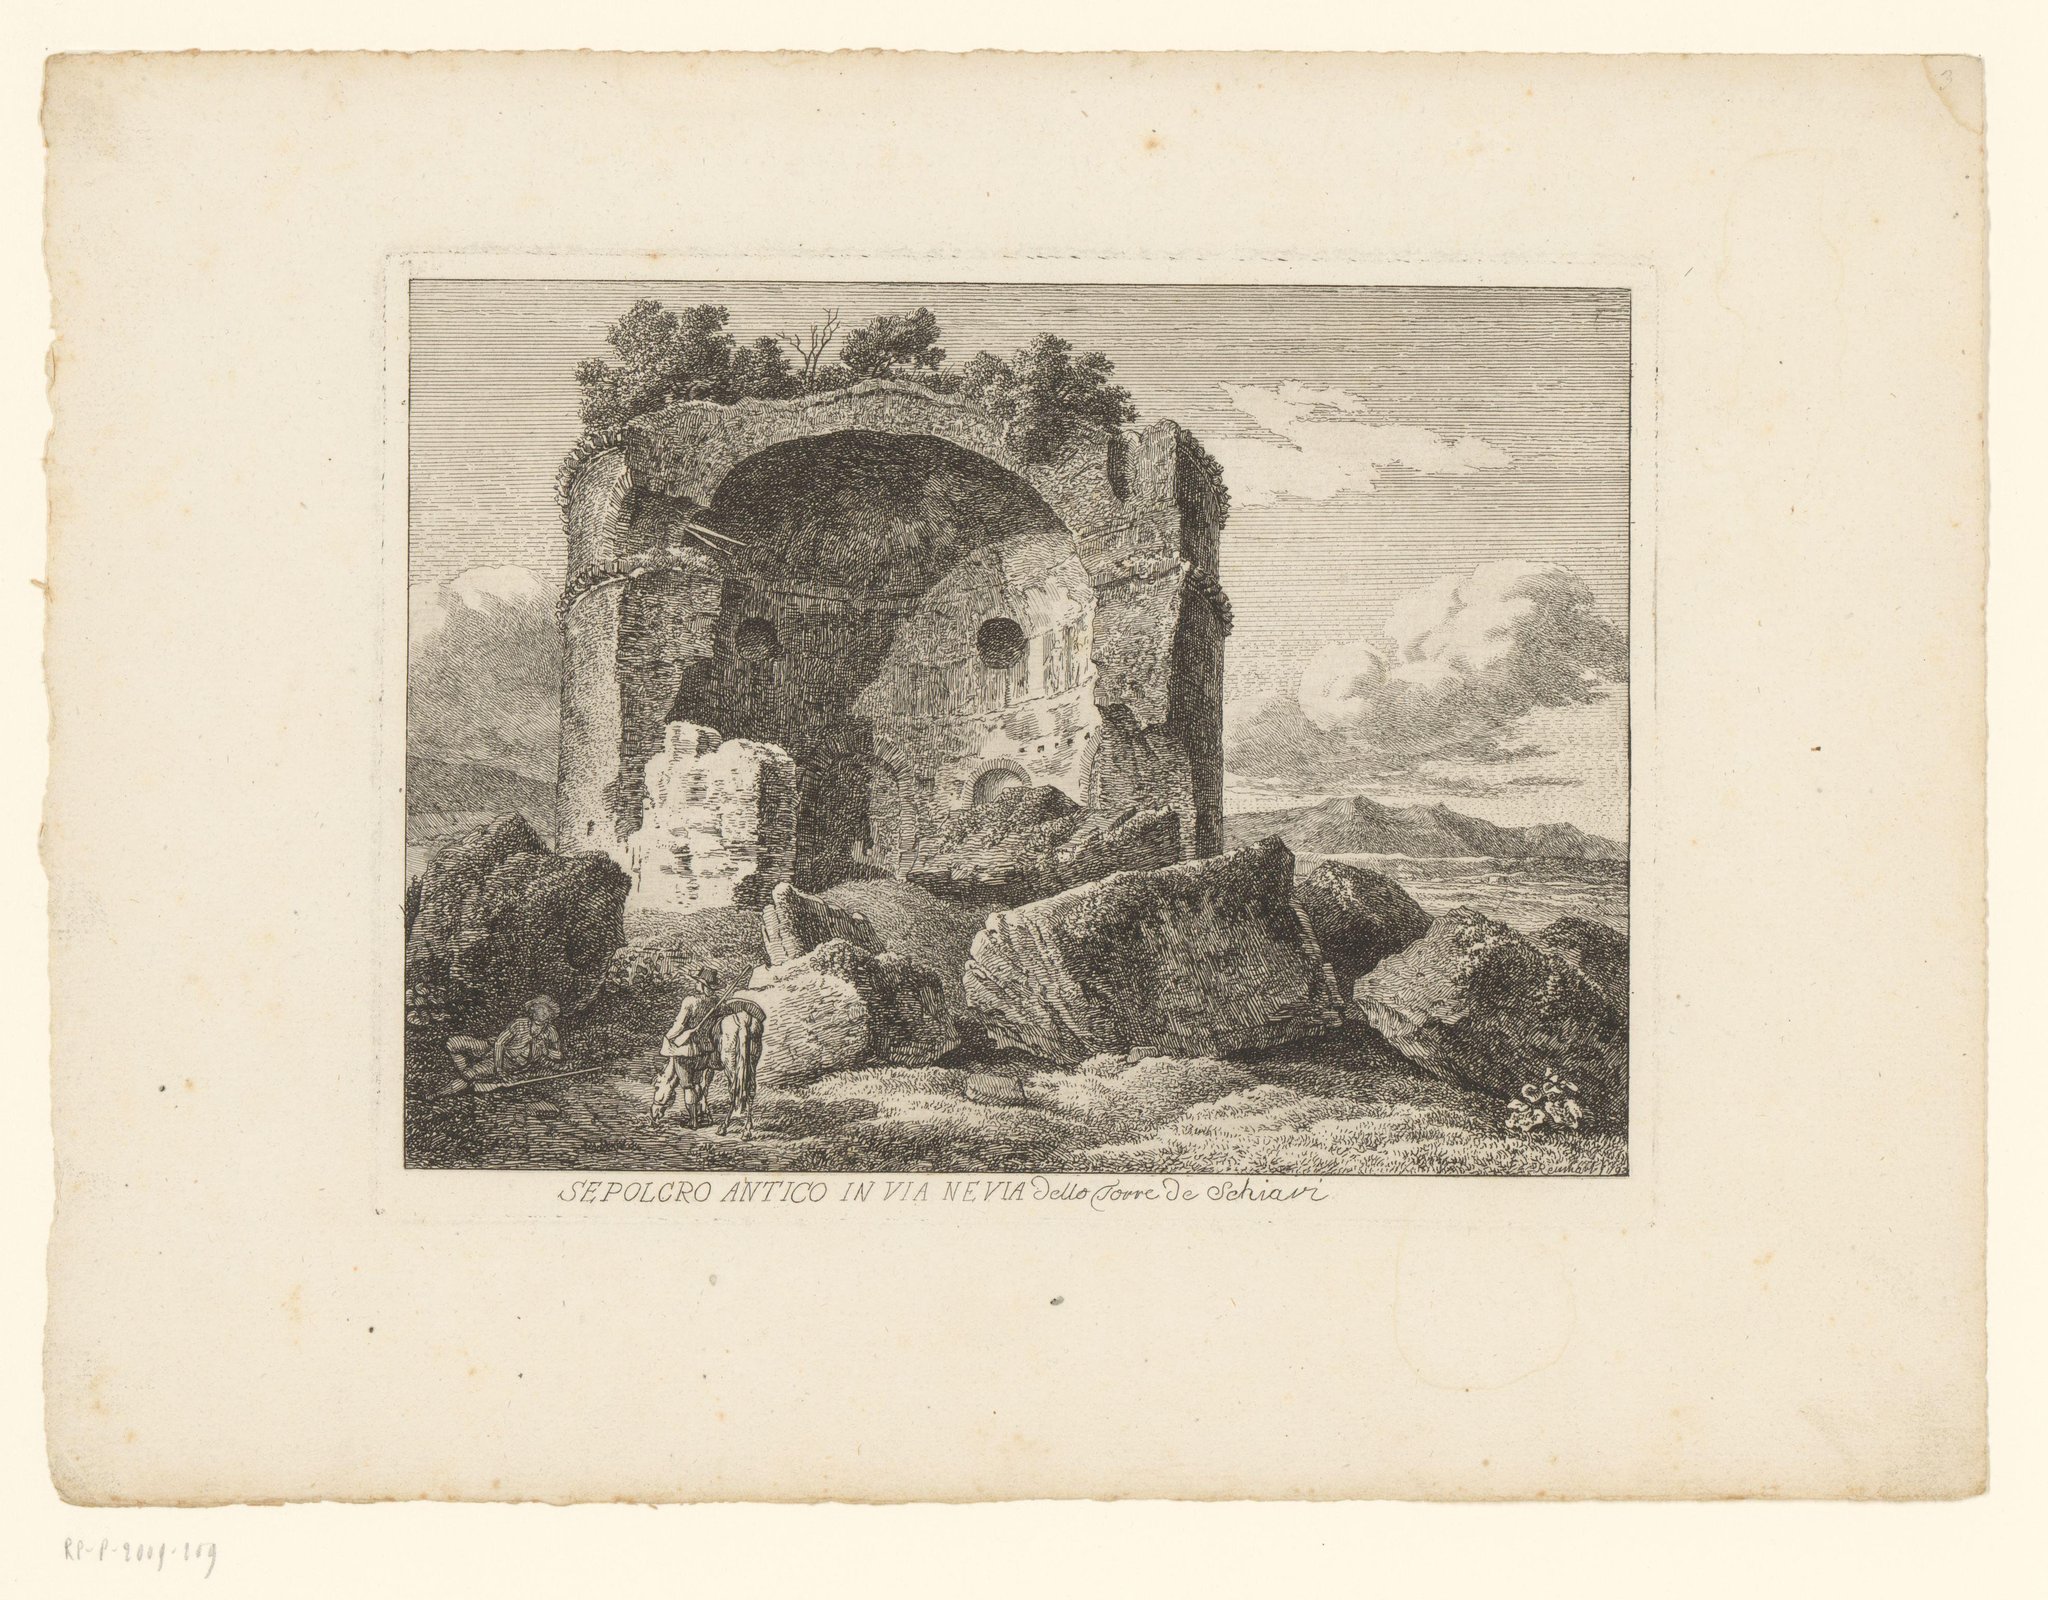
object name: print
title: Italiaanse landschappen met monumenten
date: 1792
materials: paper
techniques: etching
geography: nuremberg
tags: landscape with ruins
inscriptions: collector's mark: Lugt 2228, collector's mark: Lugt 3870, collector's mark: Lugt 2760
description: Behorend tot een serie van 72 'Mahlerisch-radirte Prospecte von Italien', waarvoor de kunstenaar 24 prenten maakte. Albert Christoph Dies (1755-1822) en Jacob Wilhelm Mechau (1745-1808) maakten eveneens 24 platen, in opdracht van Jean Fréderic Frauenholz. Vanaf 1792 verschenen telkens drie sets van twee prenten per kunstenaar. In 1798 werd de laatste set uitgegeven, waarna complete sets gebonden werden uitgegeven tot in 1875 (Nuerenberg: J.L. Lotzbeck). Zie: Schmid, F.C., A.C. Dies, J.W. Mechau und J.C. Reinhart 'Mahlerische radirte Prospecte von Italien' (...). Berlijn: s.n., 1991.